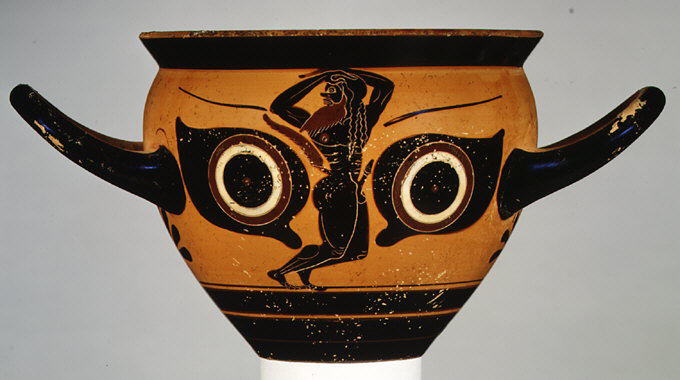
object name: mastoid with handle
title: Terracotta mastoid (drinking cup in the form of a breast)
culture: greek, attic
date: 534-501 BCE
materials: terracotta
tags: eyes,maenads,satyrs